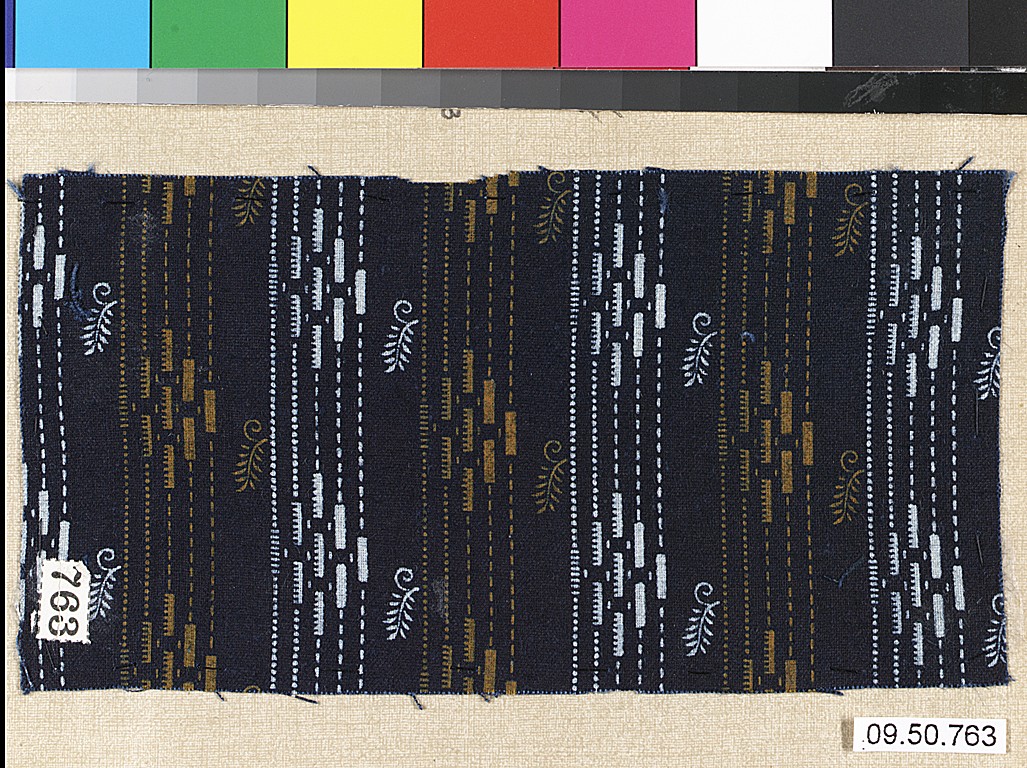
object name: piece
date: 1801-1900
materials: cotton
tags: leaves